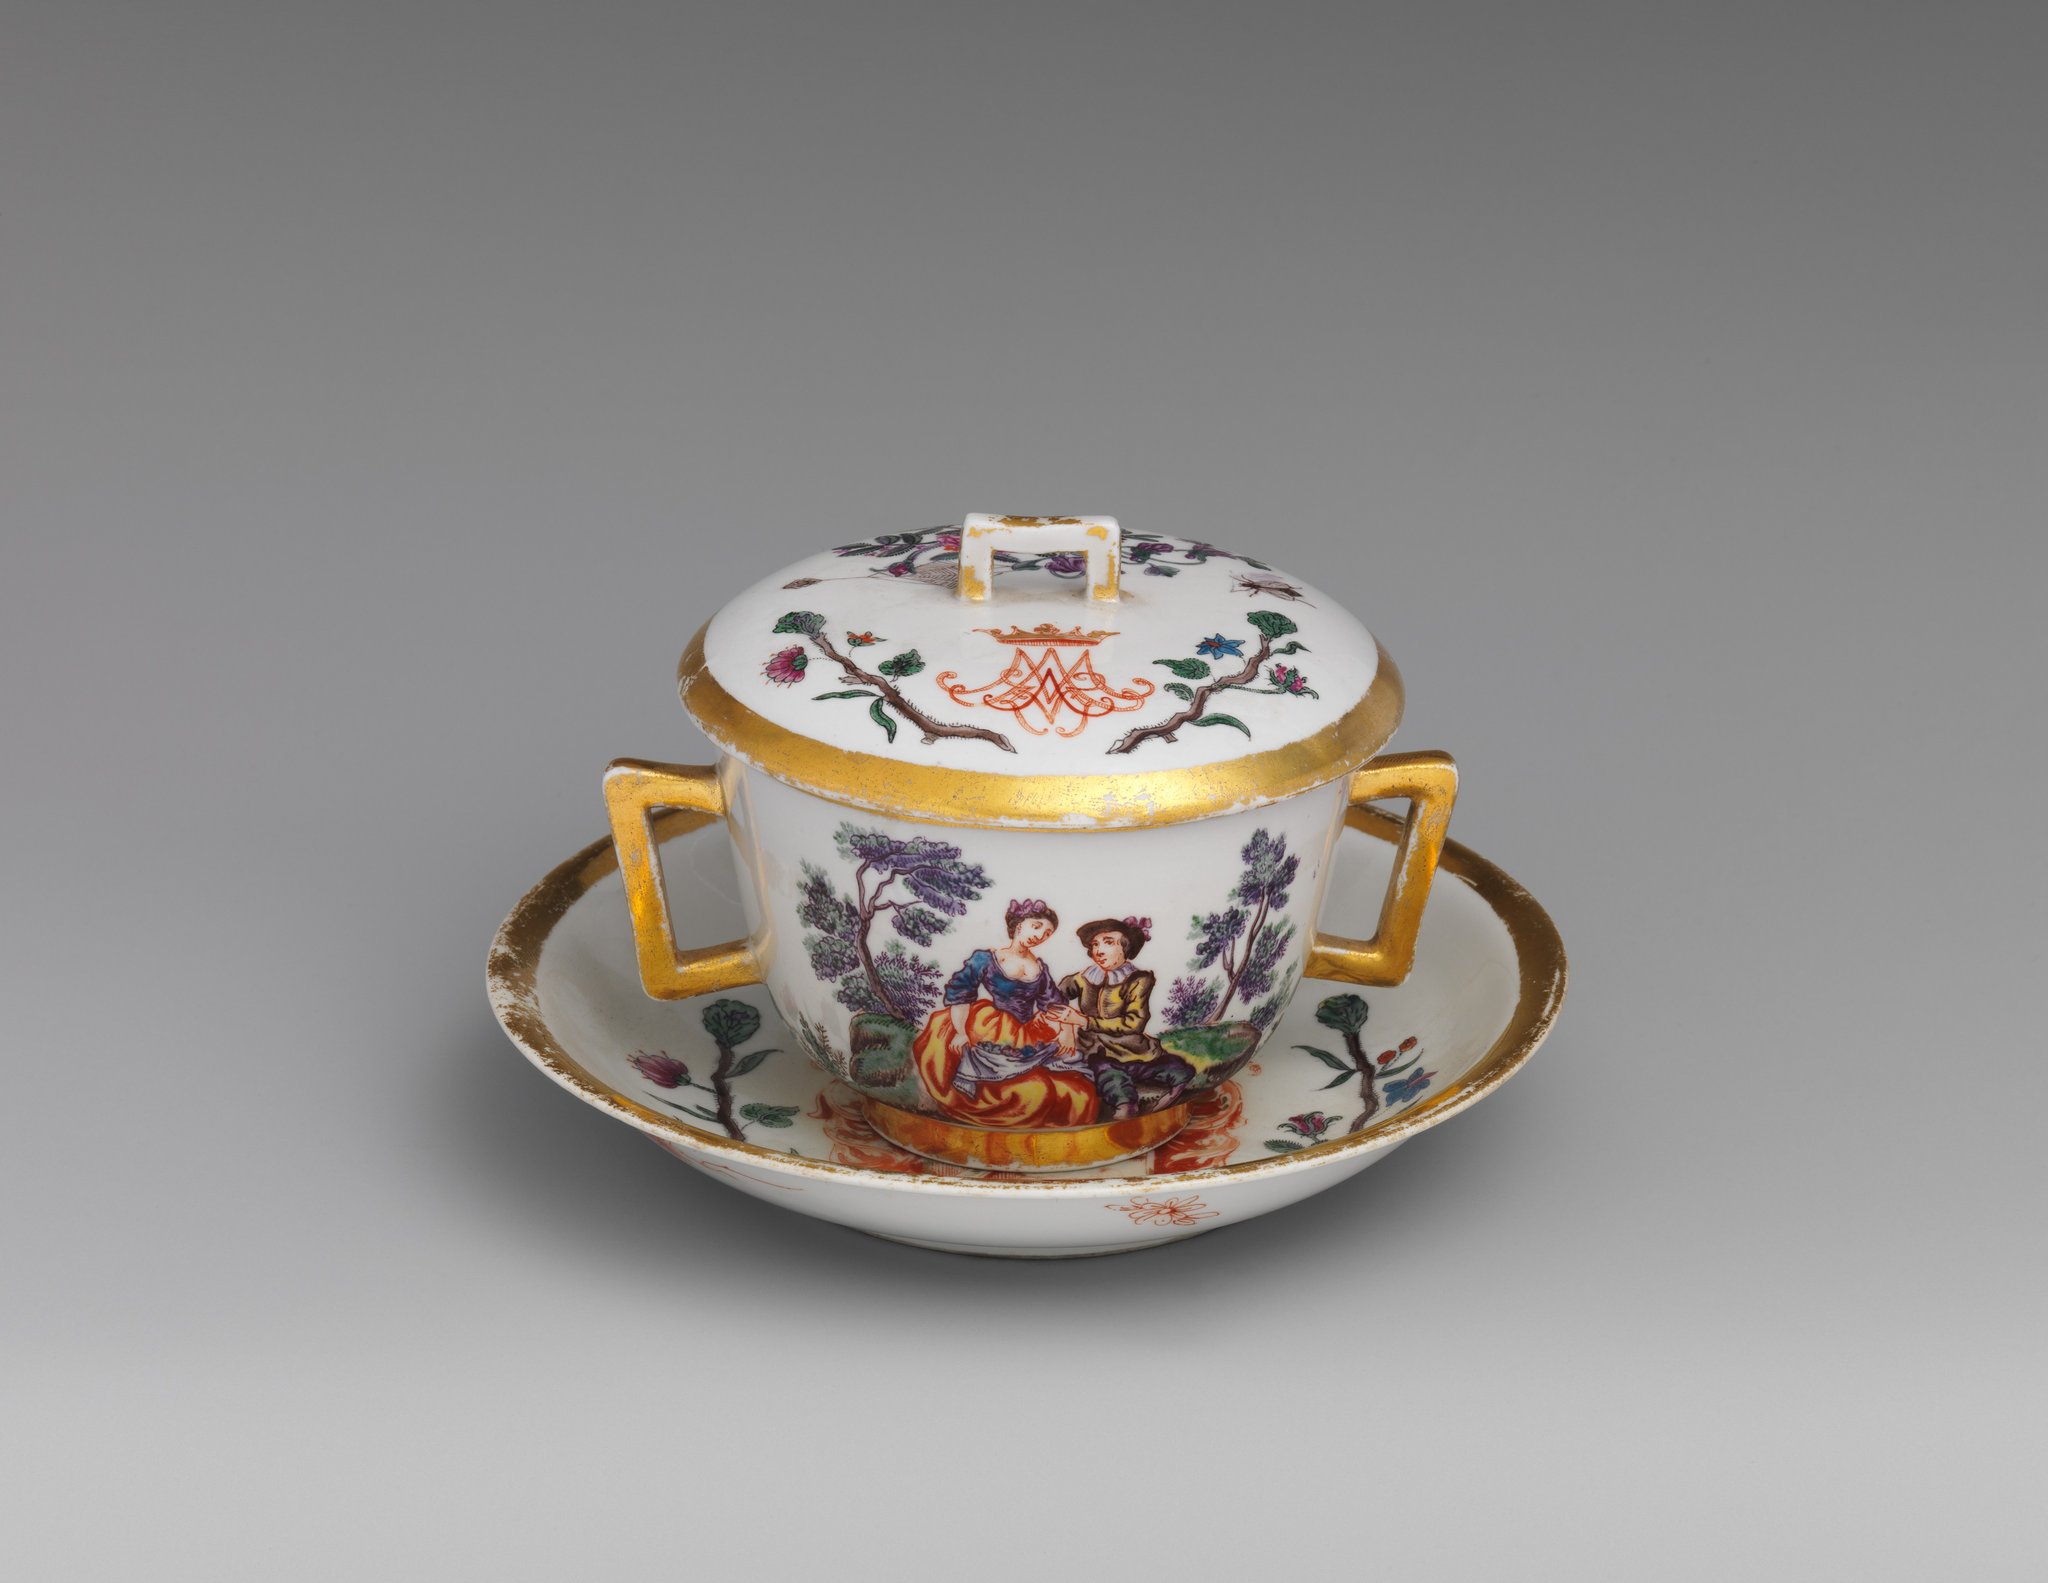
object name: tureen and stand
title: Small tureen and stand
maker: vienna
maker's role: manufactory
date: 1730-1735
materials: hard paste porcelain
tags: men,women,insignia